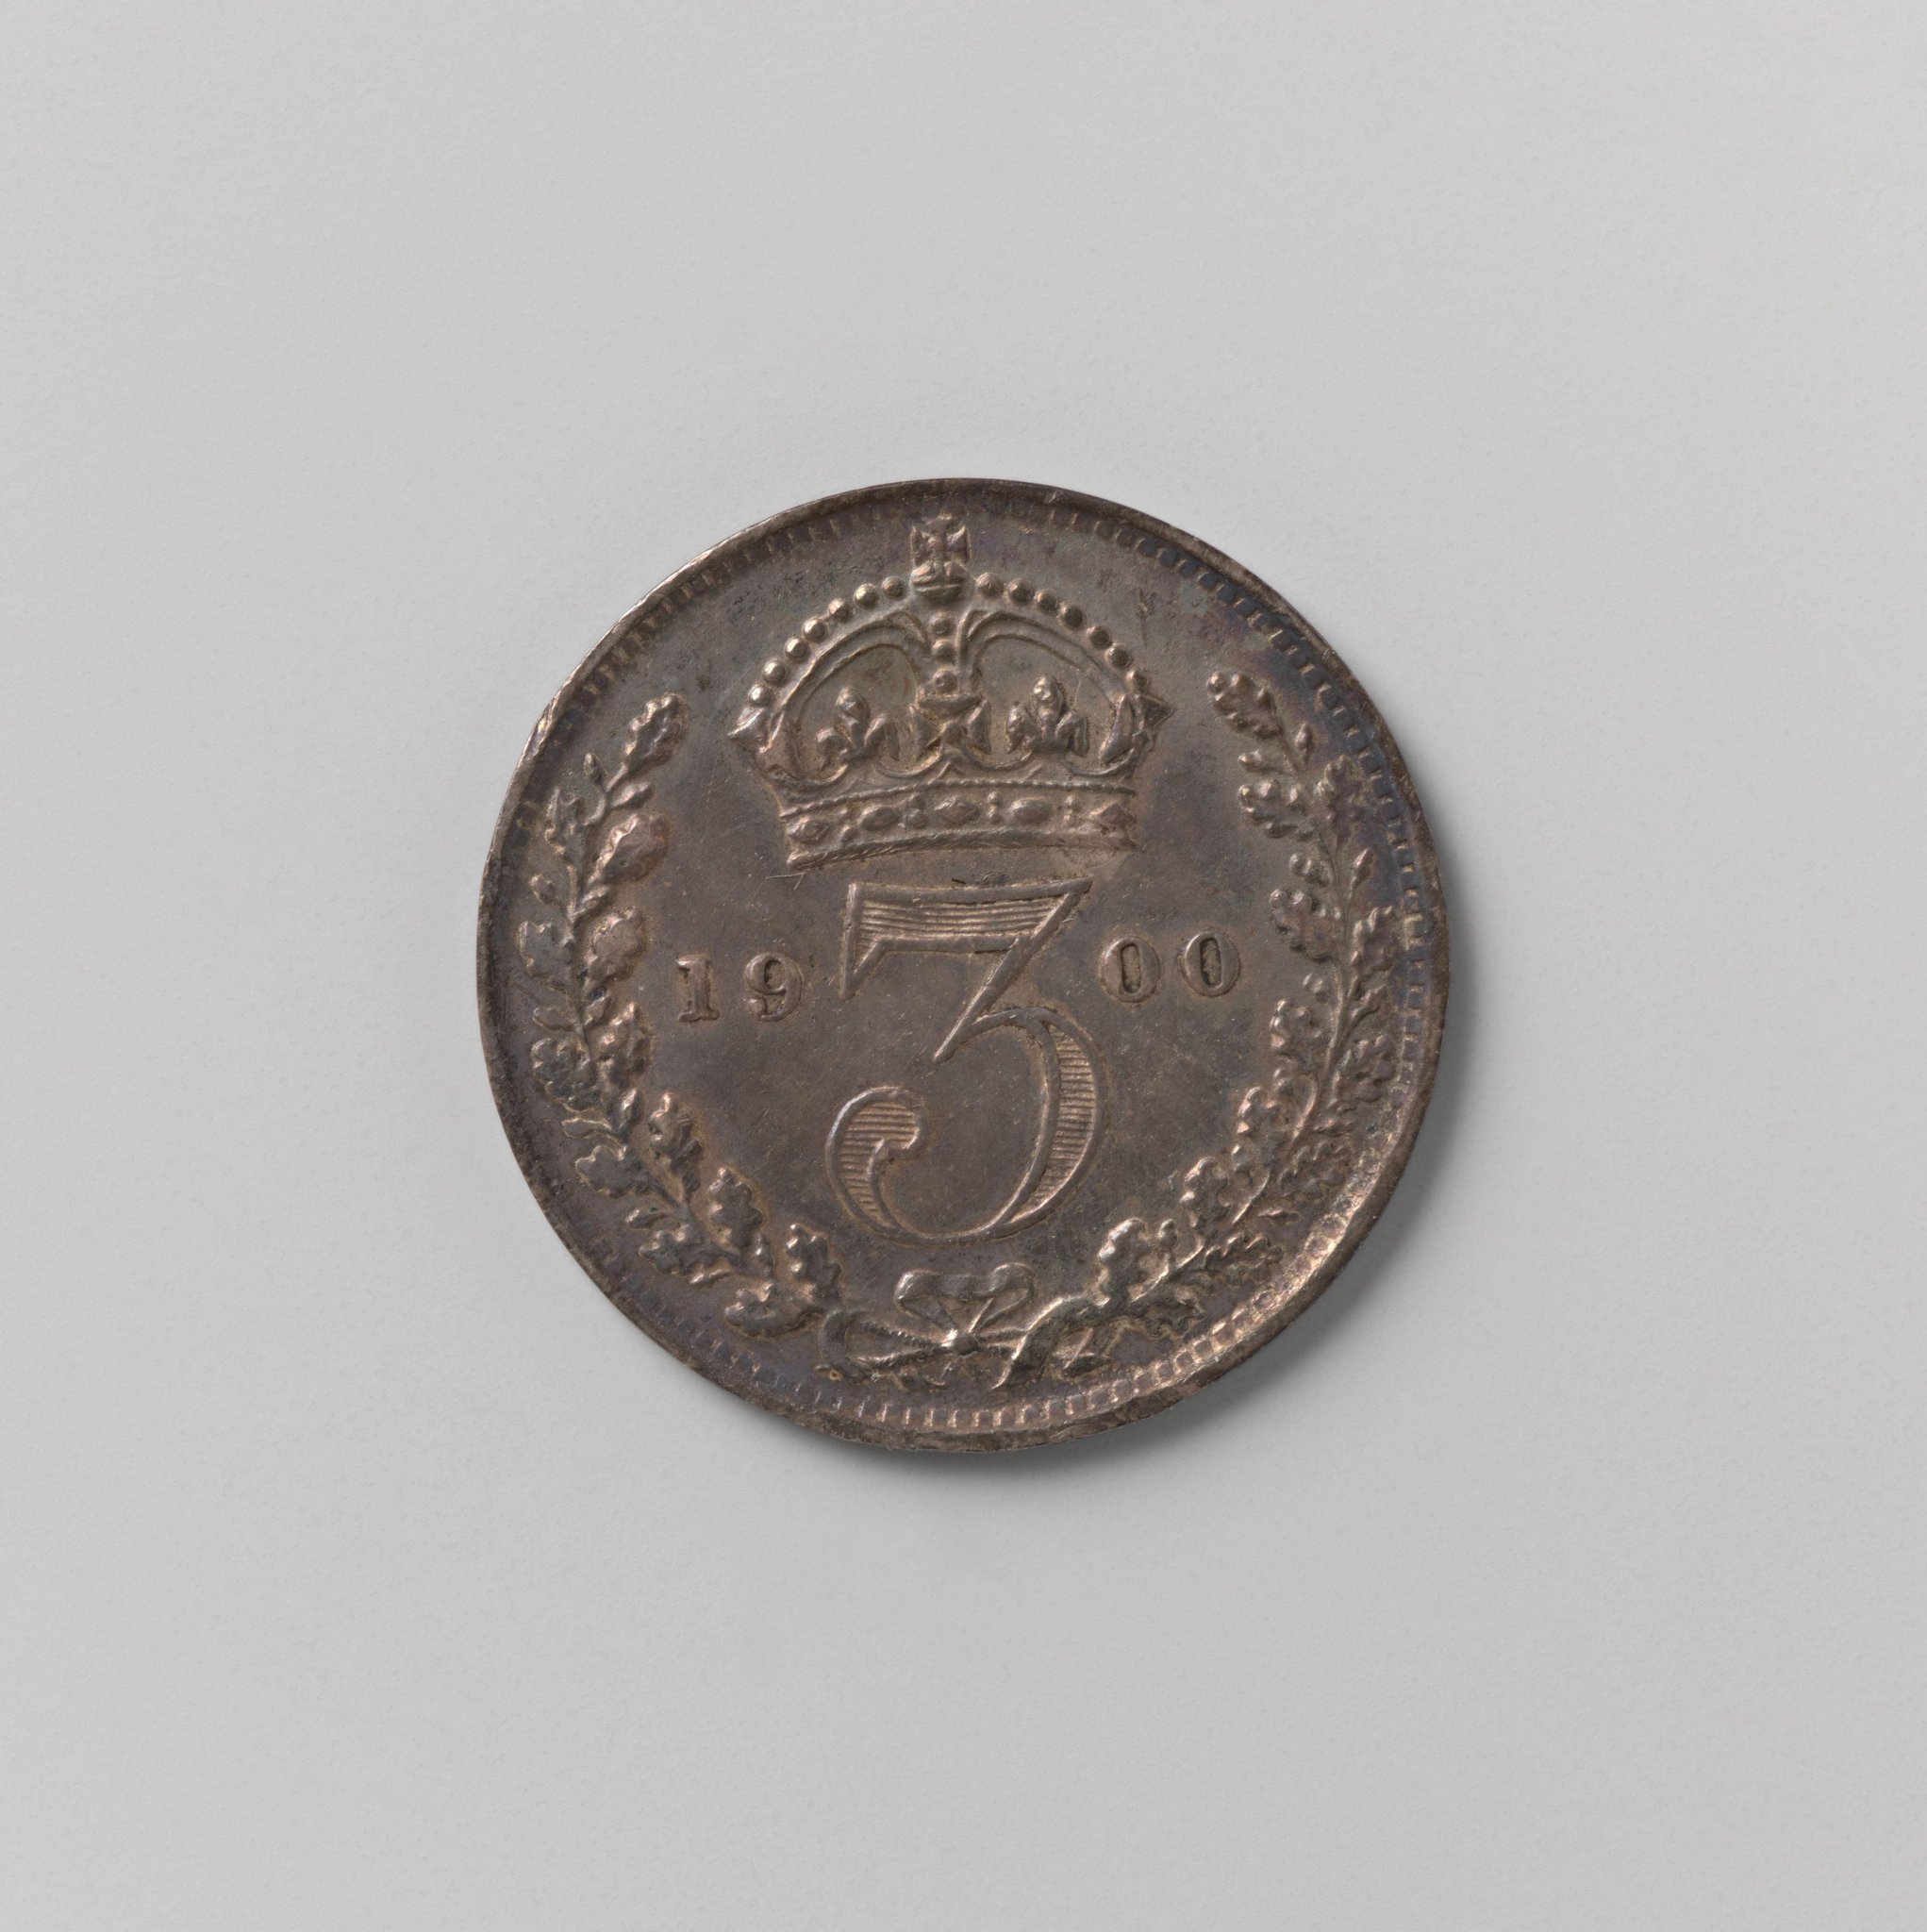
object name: coin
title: 3 pence uit Engeland van Victoria, 1899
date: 1899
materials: silver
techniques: striking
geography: london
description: Zilveren munt. Voorzijde: gekroond borstbeeld van de koningin naar links [old head]. Keerzijde: binnen samengebonden laurier- en eikentak waarde-aanduiding in twee regels. Daarboven kroon. Jaartal onderaan. Kartelrand.